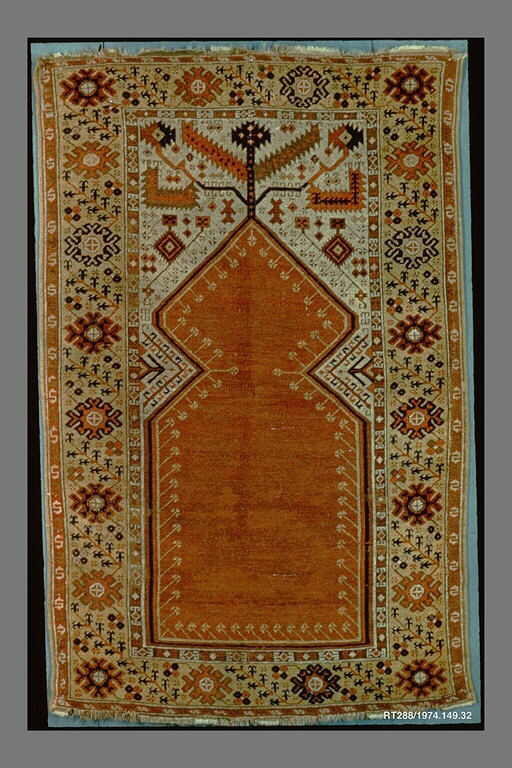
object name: carpet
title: Carpet with Niche Design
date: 1767-1833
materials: wool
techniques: pile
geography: turkey